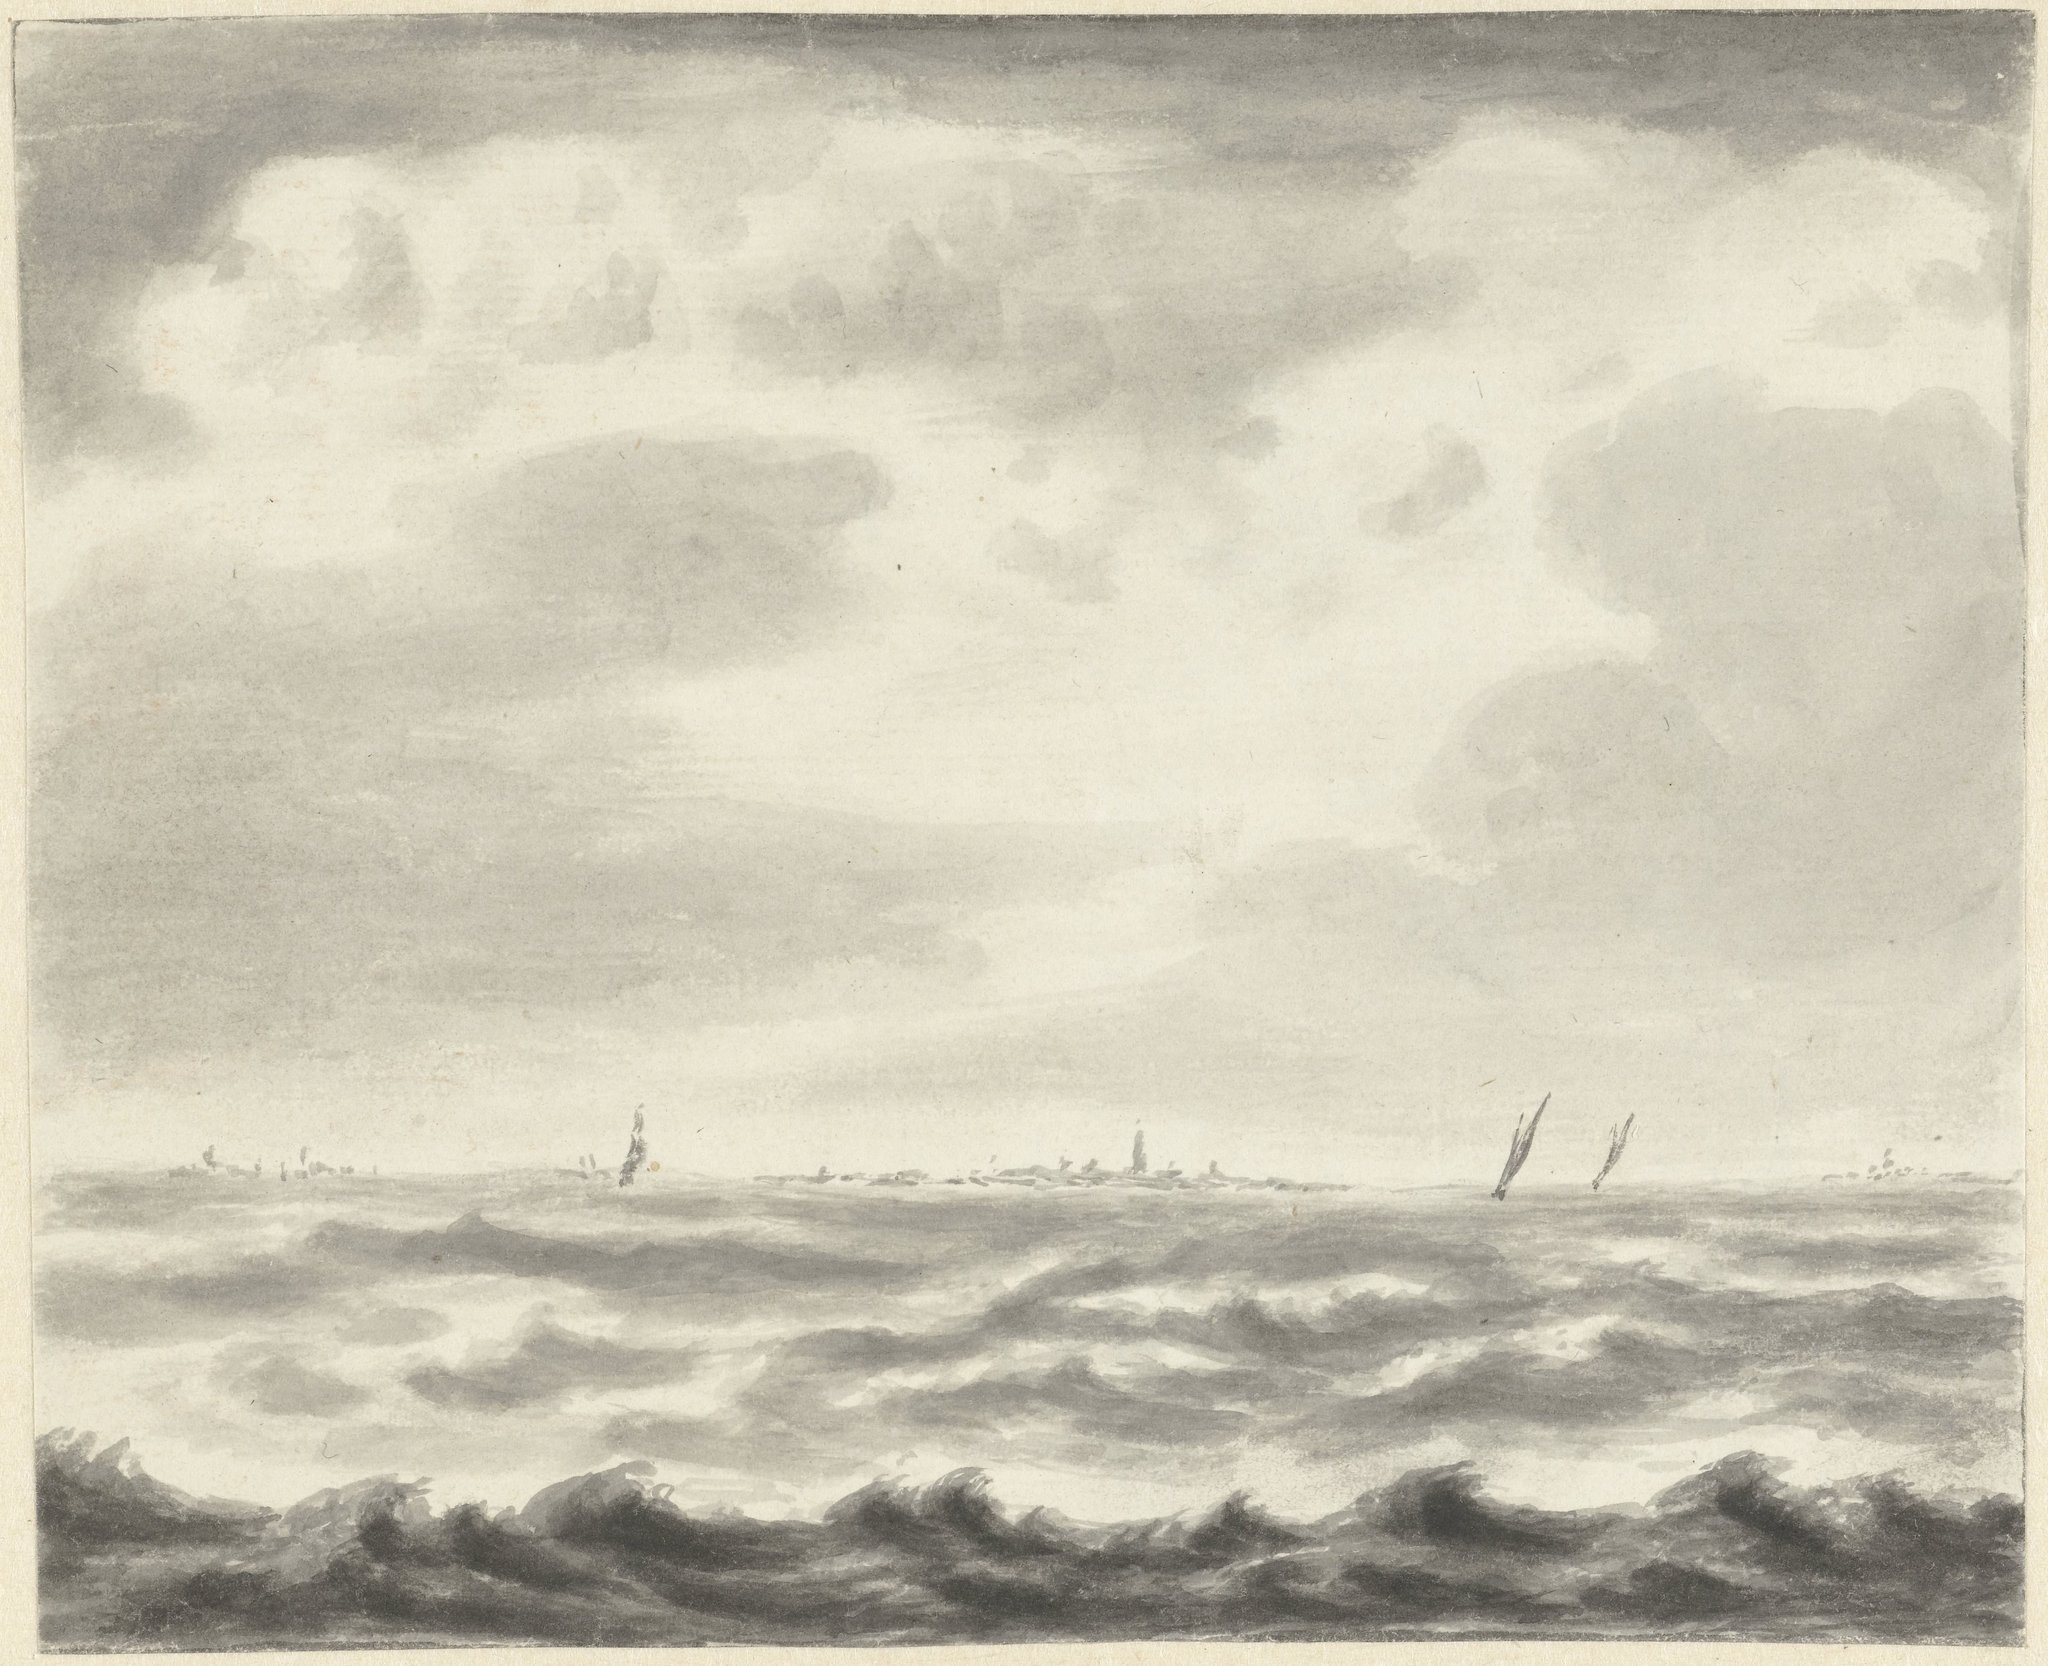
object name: drawing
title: Zeegezicht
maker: pieter idserts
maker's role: draughtsman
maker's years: 1698-1781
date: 1708-1781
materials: paper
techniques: brush